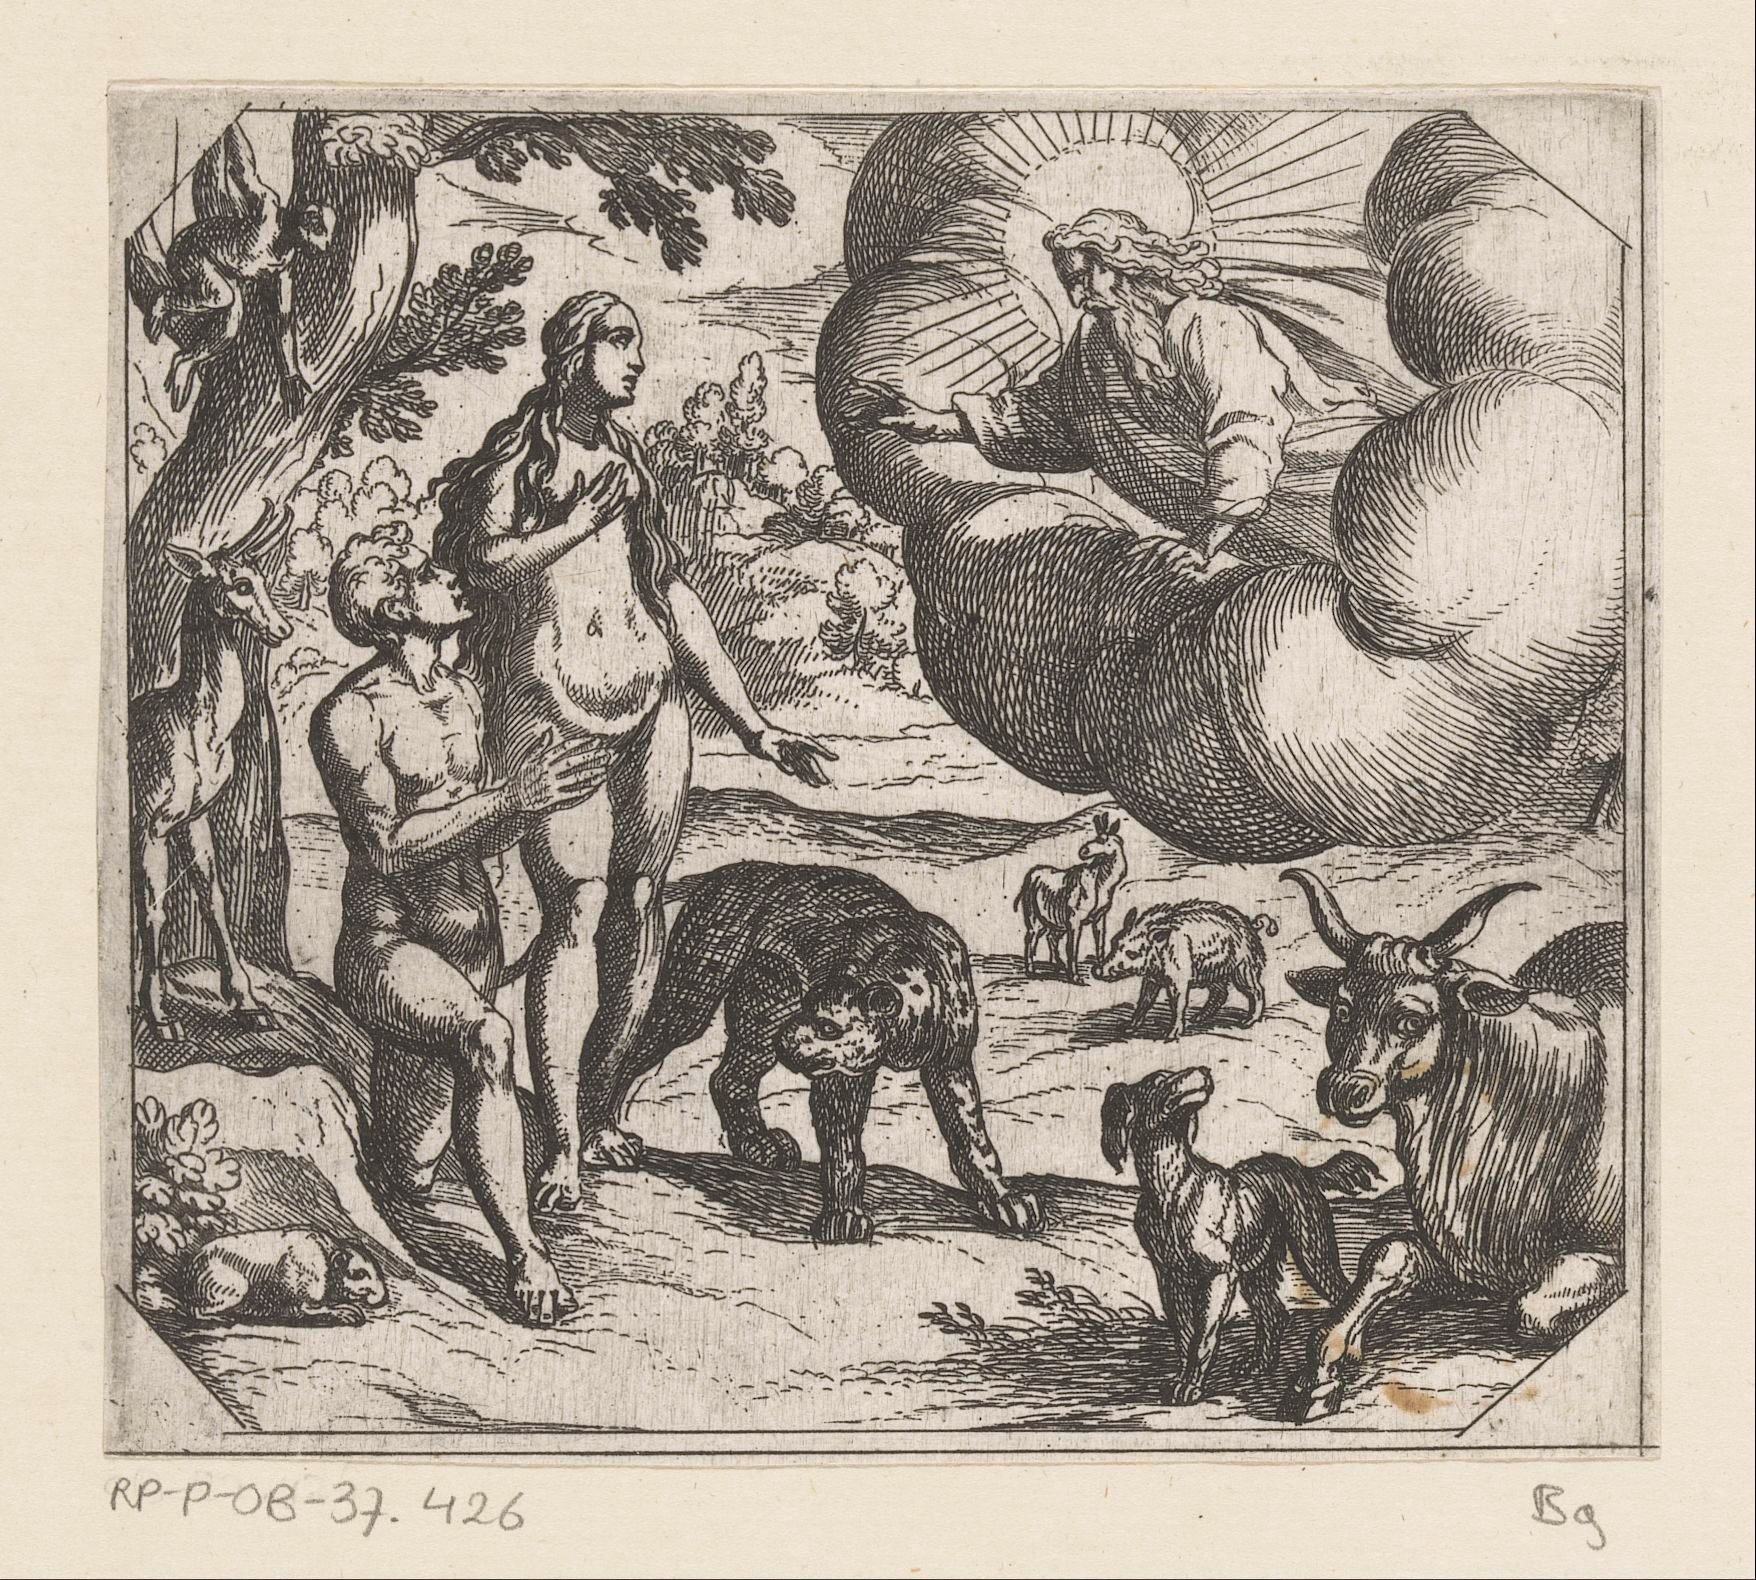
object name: print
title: De schepping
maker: antonio tempesta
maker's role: draughtsman, painter, print maker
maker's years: 1555-1630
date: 1565-1630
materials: paper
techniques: etching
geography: rome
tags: adam and eve in paradise (before the fall)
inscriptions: collector's mark: Lugt 240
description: Deze prent maakt deel uit van een serie van twaalf prenten van de schepping. De prenten zijn deels naar ontwerpen van Rafaël voor de Loggia van Rafaël in het Vaticaan, en deels naar prenten door Nicolaes de Bruyn naar ontwerpen van Maerten de Vos (zie: Holl. Dutch. vol. 45 nr. 1-10).